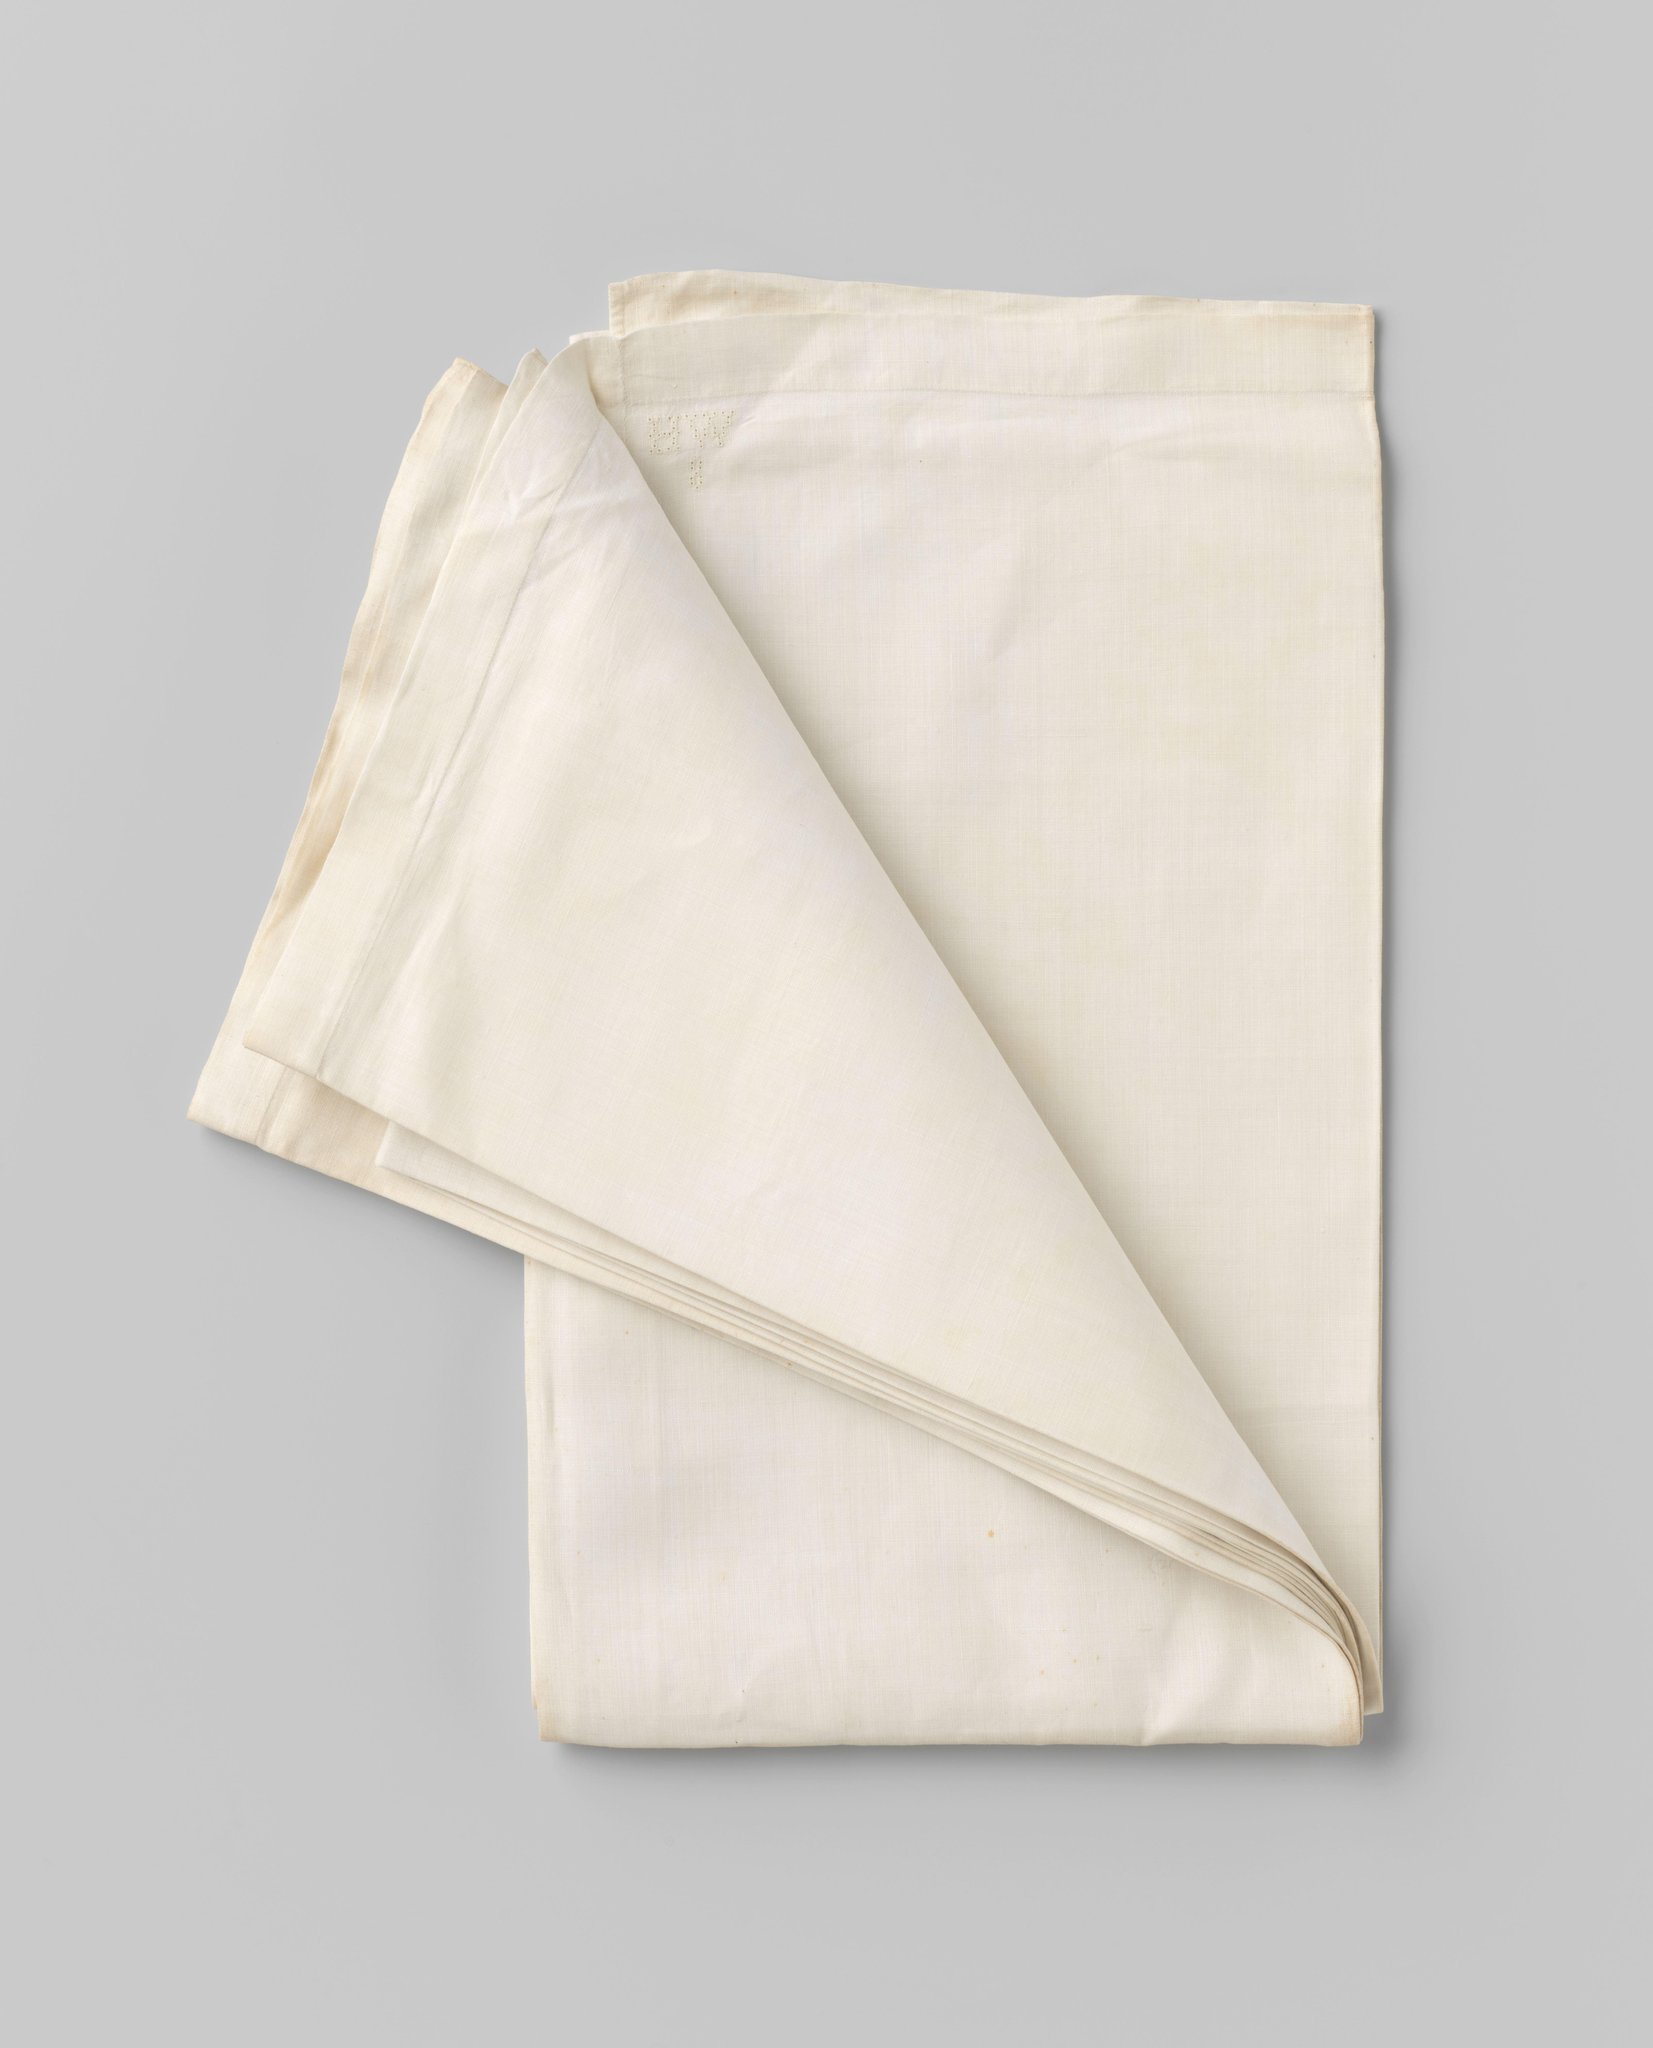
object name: beddenlaken, laken object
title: Laken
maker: Anonymous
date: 1839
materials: linen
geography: northern netherlands